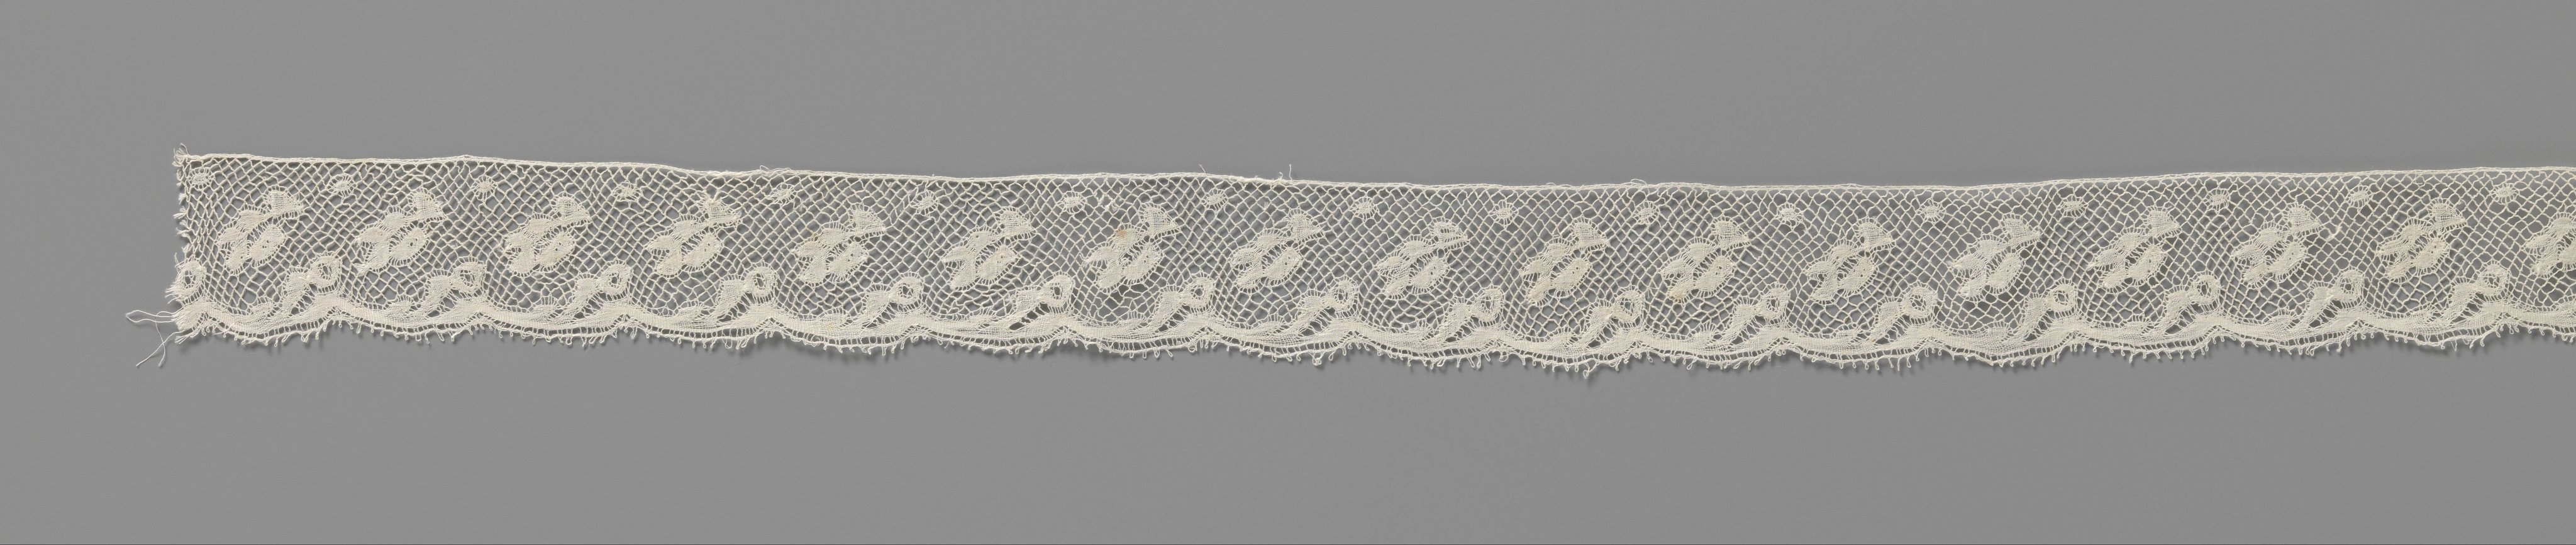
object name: strip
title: Strook kloskant met vallend blaadje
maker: Anonymous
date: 1910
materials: linen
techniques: lace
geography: netherlands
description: Op een fond van vierkante mazen staan vallende blaadjes boven vlakke schulpjes, die gevuld zijn met een omgekeerd V-vormig blad met bes. Valenciennes-kant.